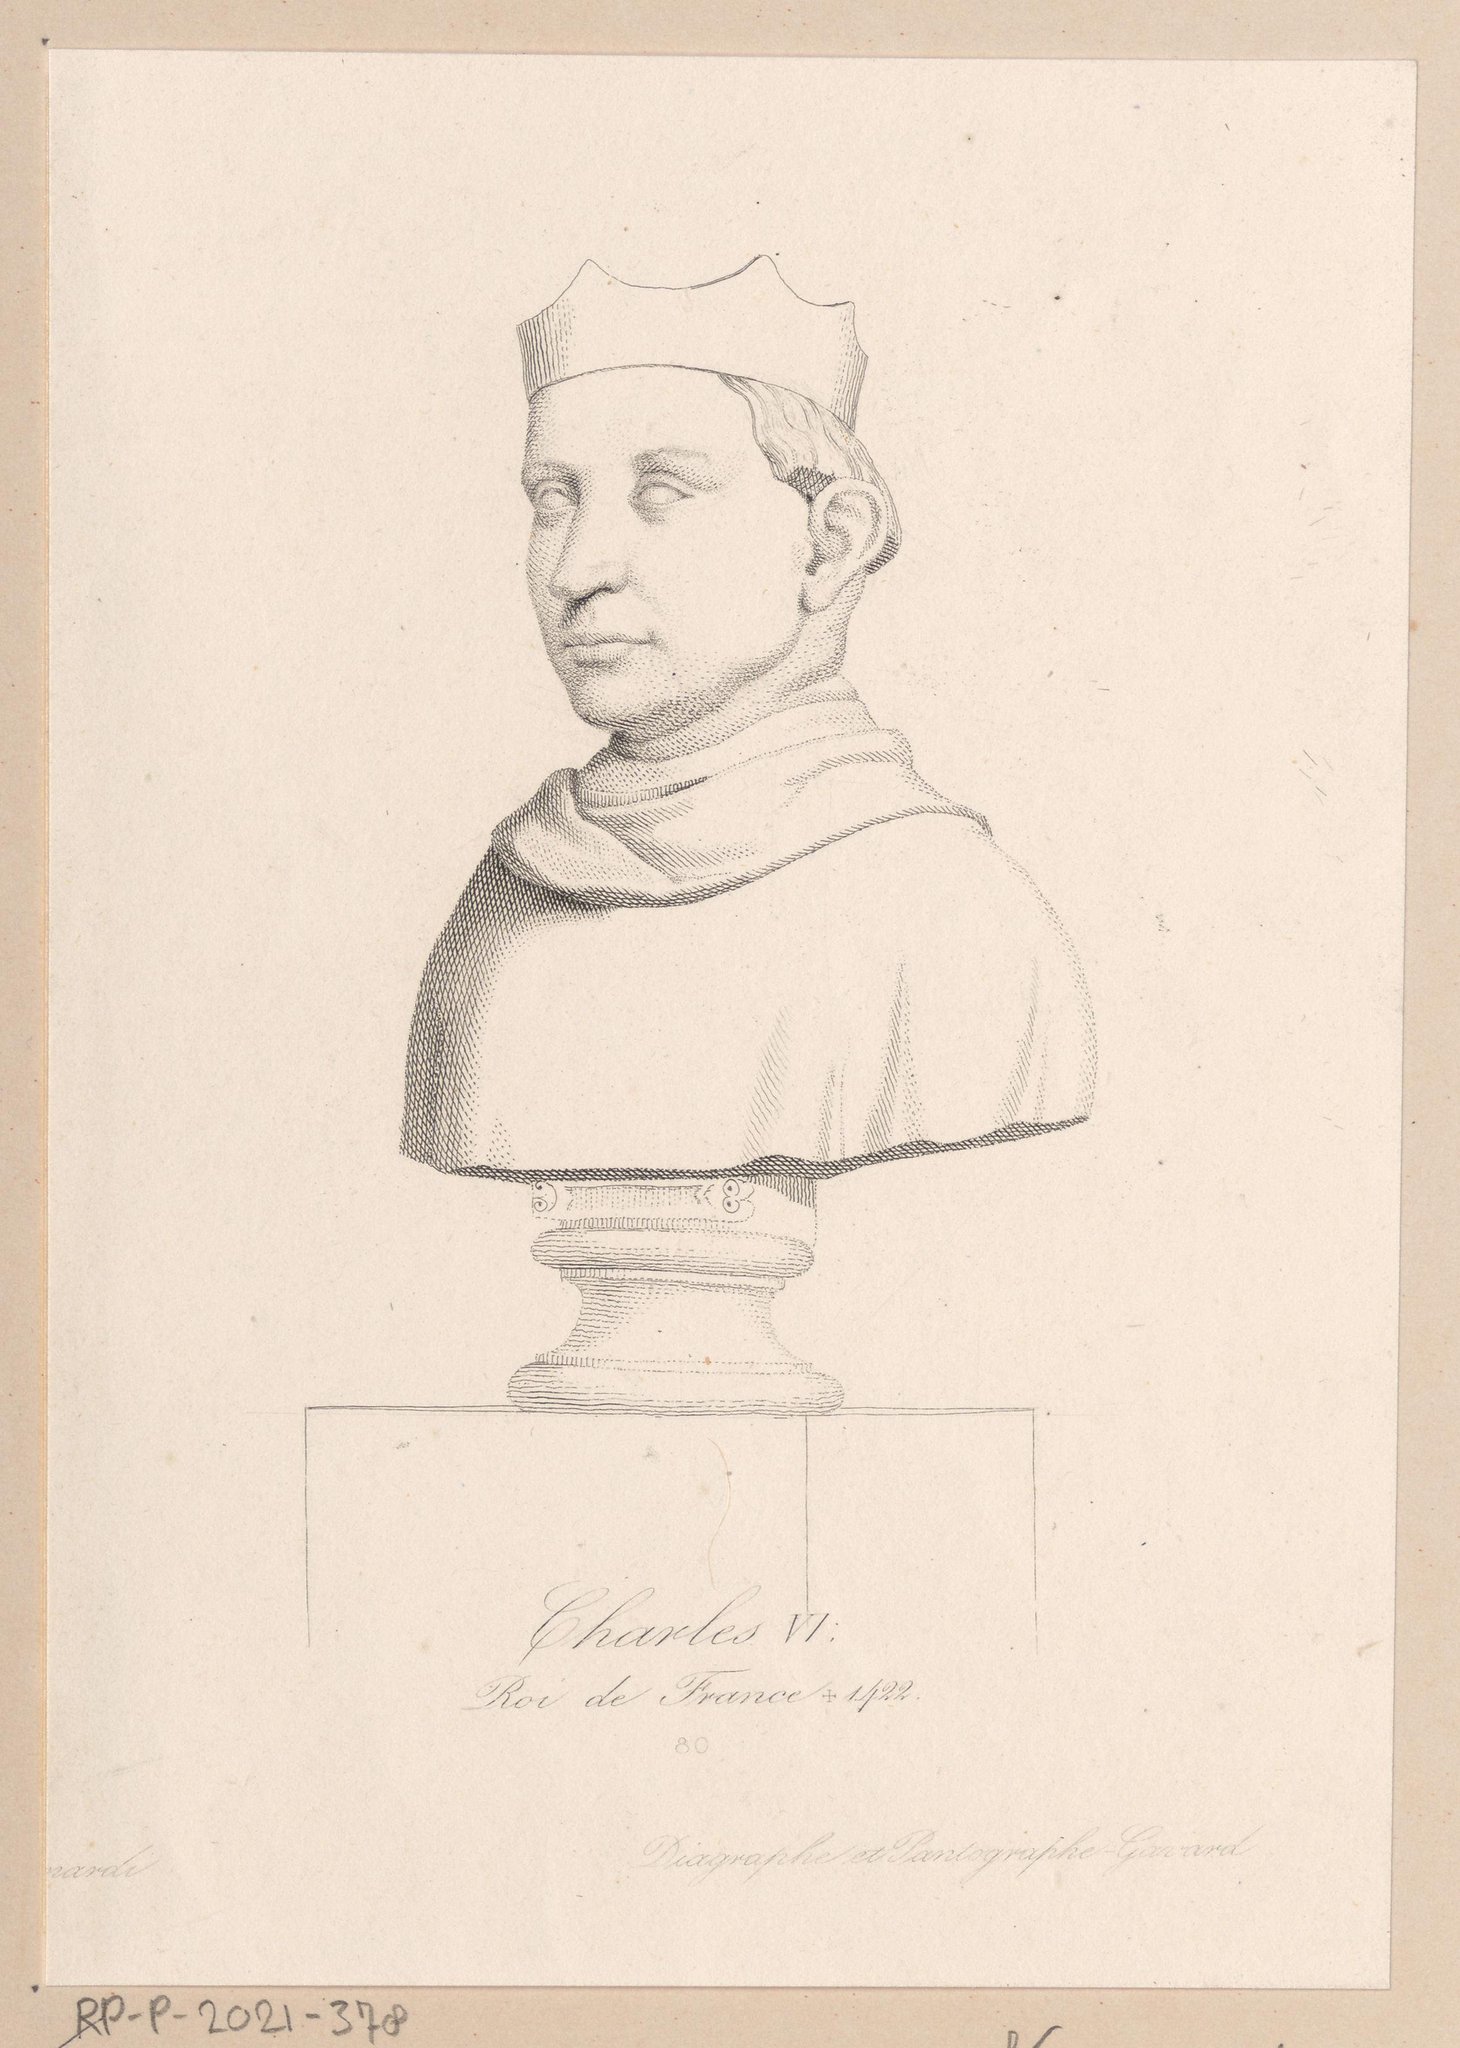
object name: print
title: Portret van Karel VI, koning van Frankrijk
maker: charles gavard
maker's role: print maker, publisher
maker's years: 1794-1871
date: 1804-1871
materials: paper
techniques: etching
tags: paris, historical persons, king